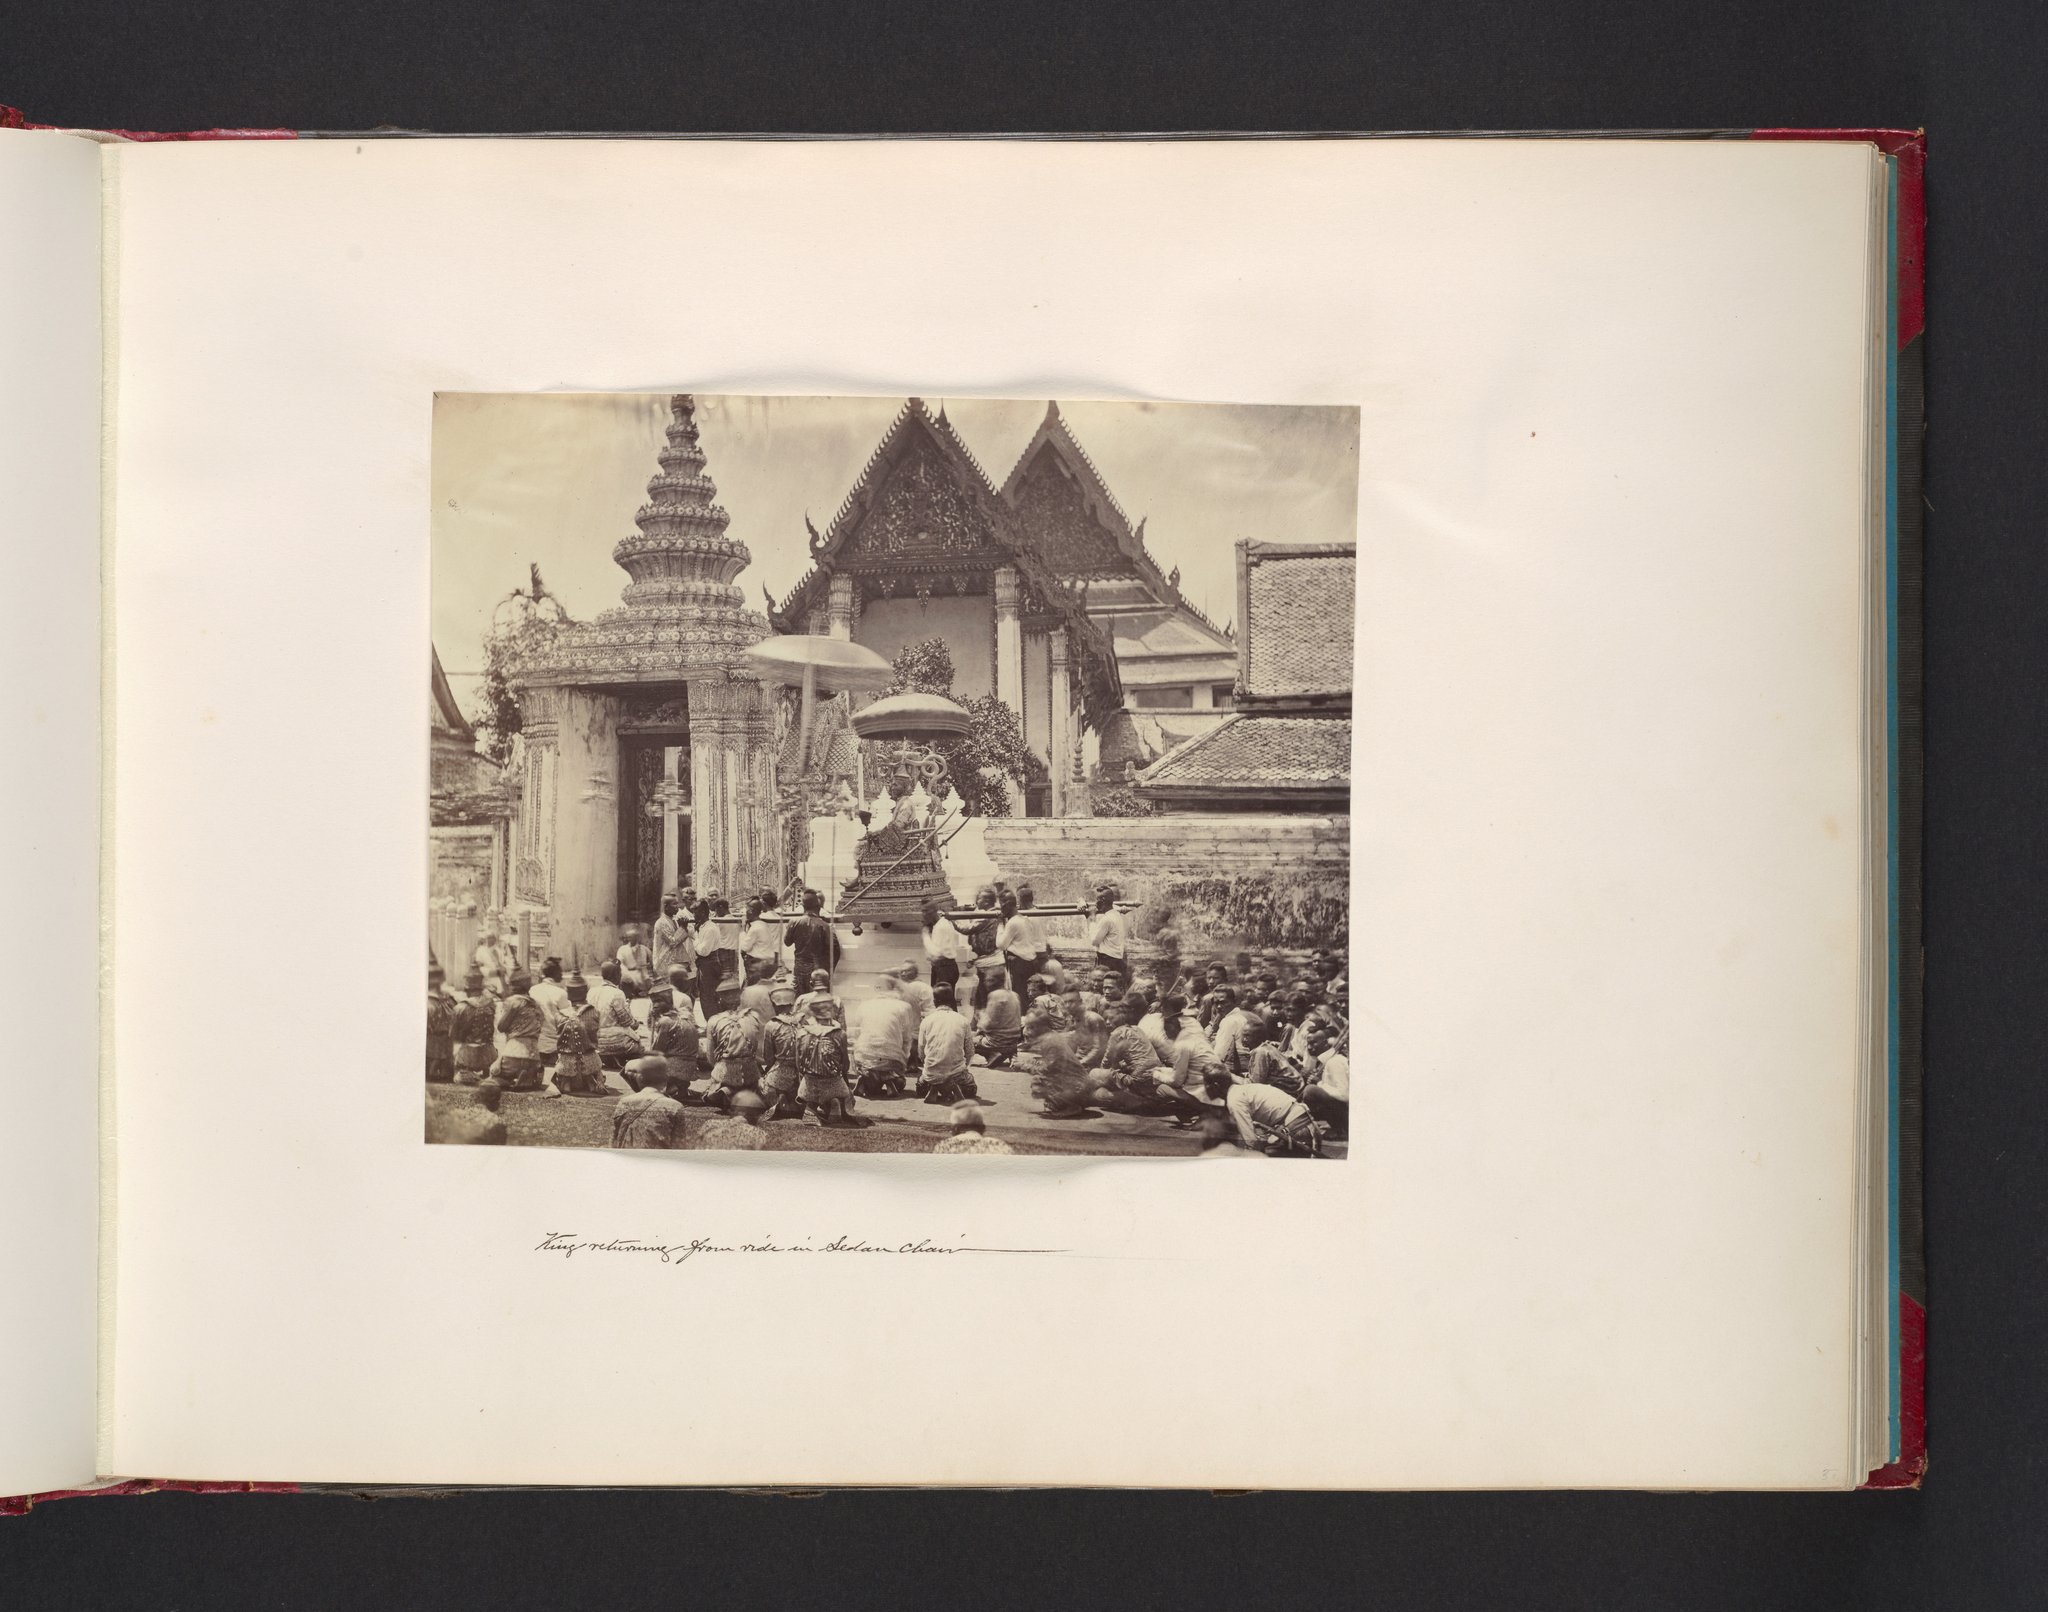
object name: photograph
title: King Returning from Ride in Sedan Chair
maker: john thomson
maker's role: artist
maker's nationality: british, scottish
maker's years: 1837-1921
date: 1865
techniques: albumen silver print, glass negative